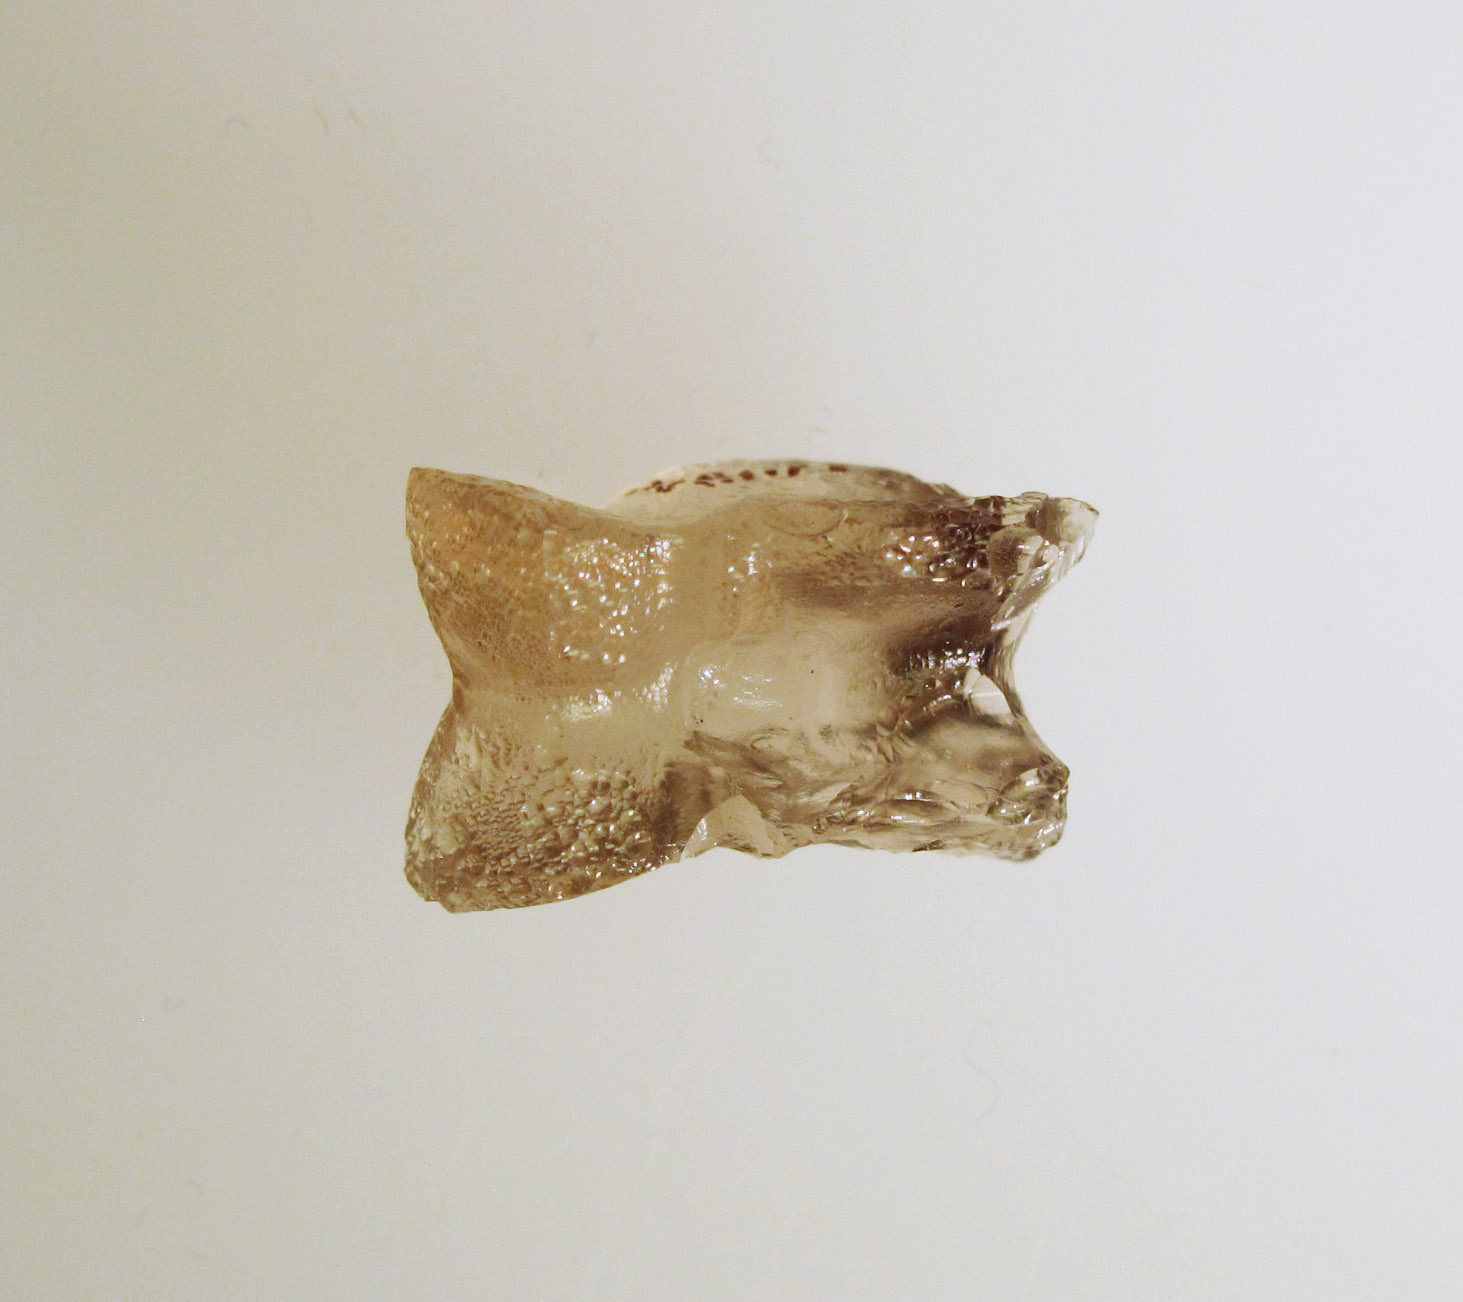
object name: astragal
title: Glass astragal (knucklebone)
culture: greek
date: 300-101 BCE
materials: glass